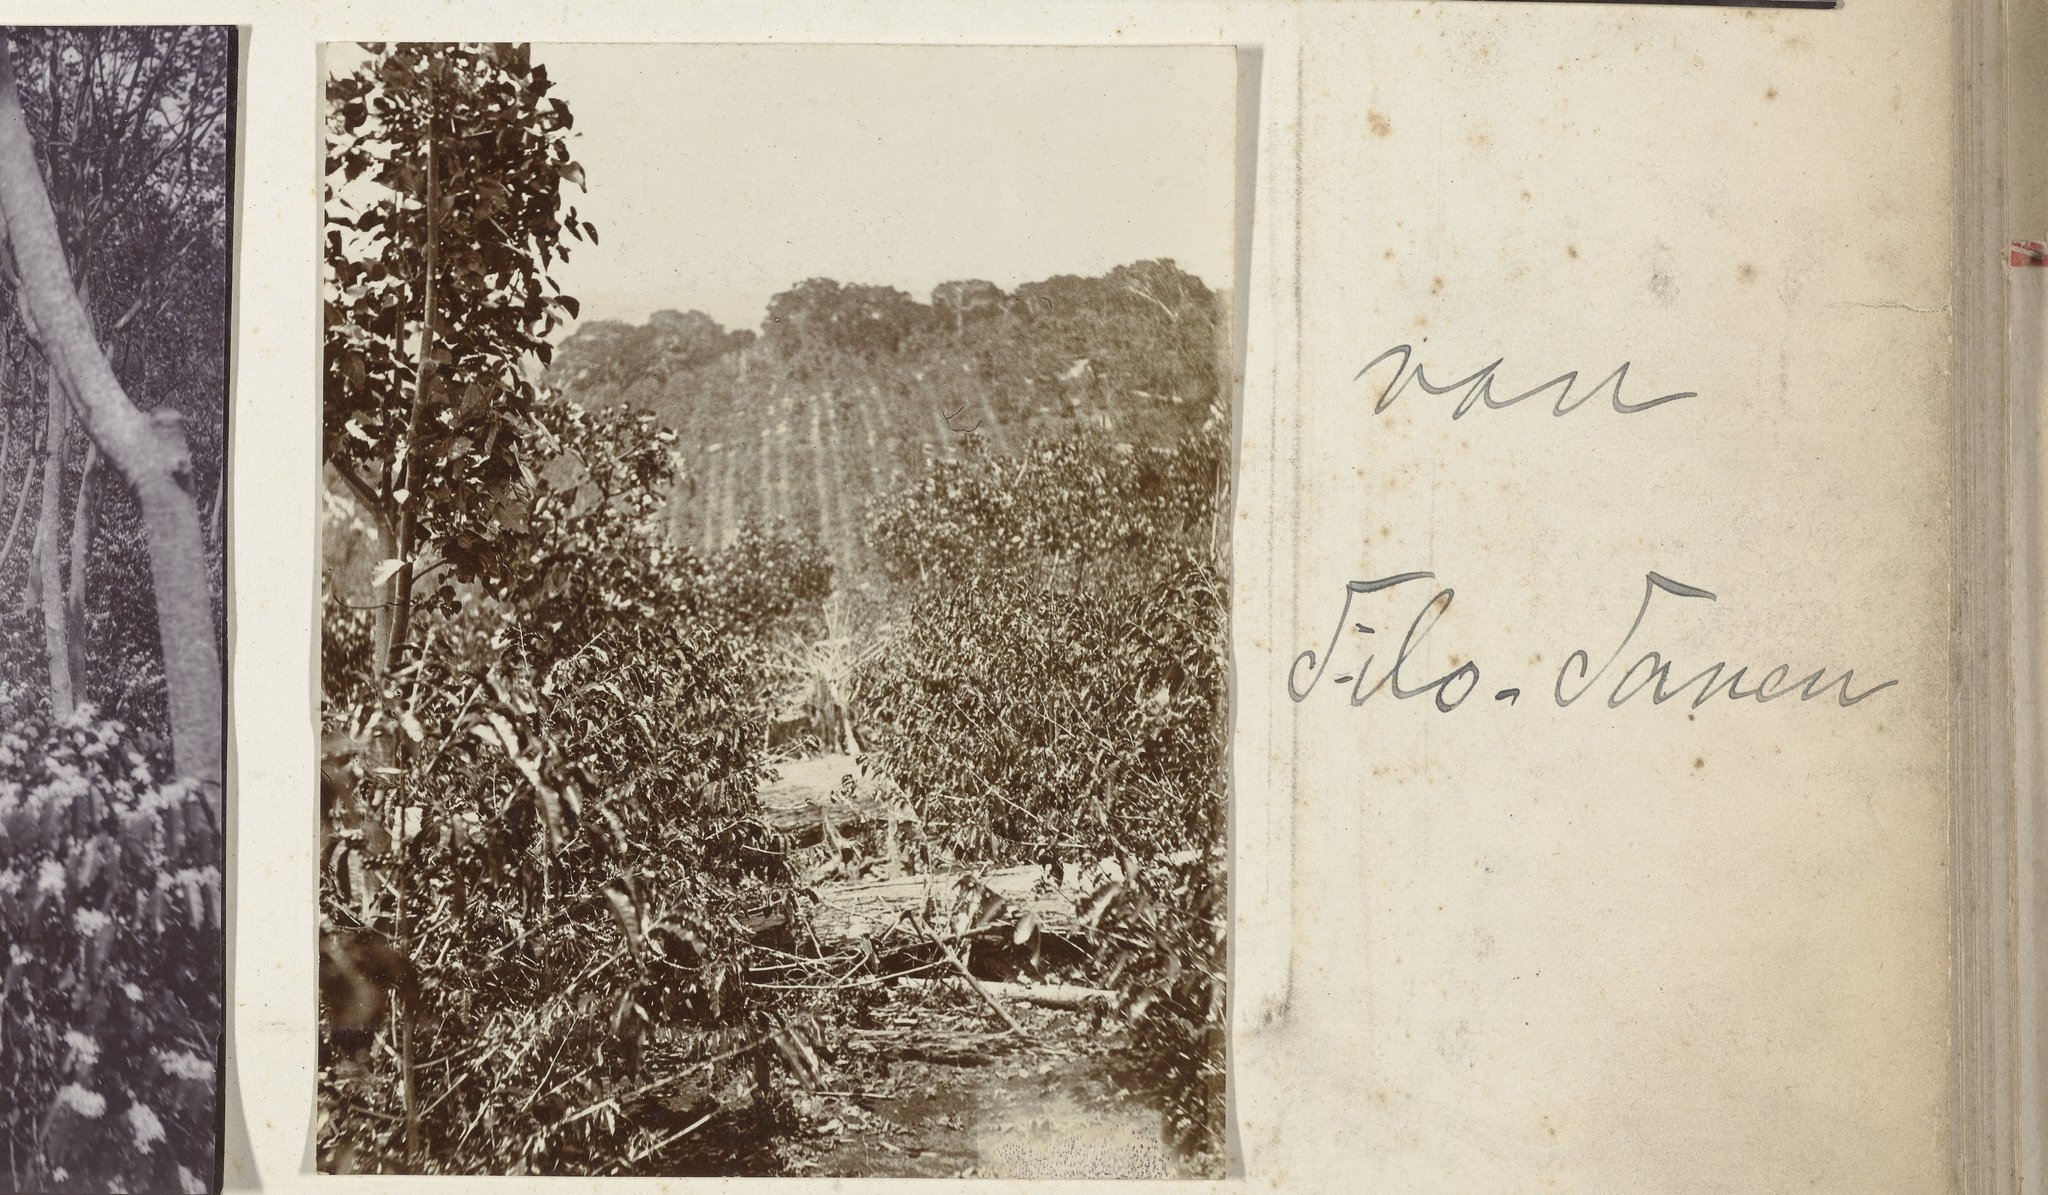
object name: photograph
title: Koffievelden van plantage Silo Sanen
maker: Anonymous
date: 1890-1910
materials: cardboard, paper, photographic support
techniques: gelatin silver print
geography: indonesia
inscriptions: caption: ‘Koffietuinen van Silo Sanen’